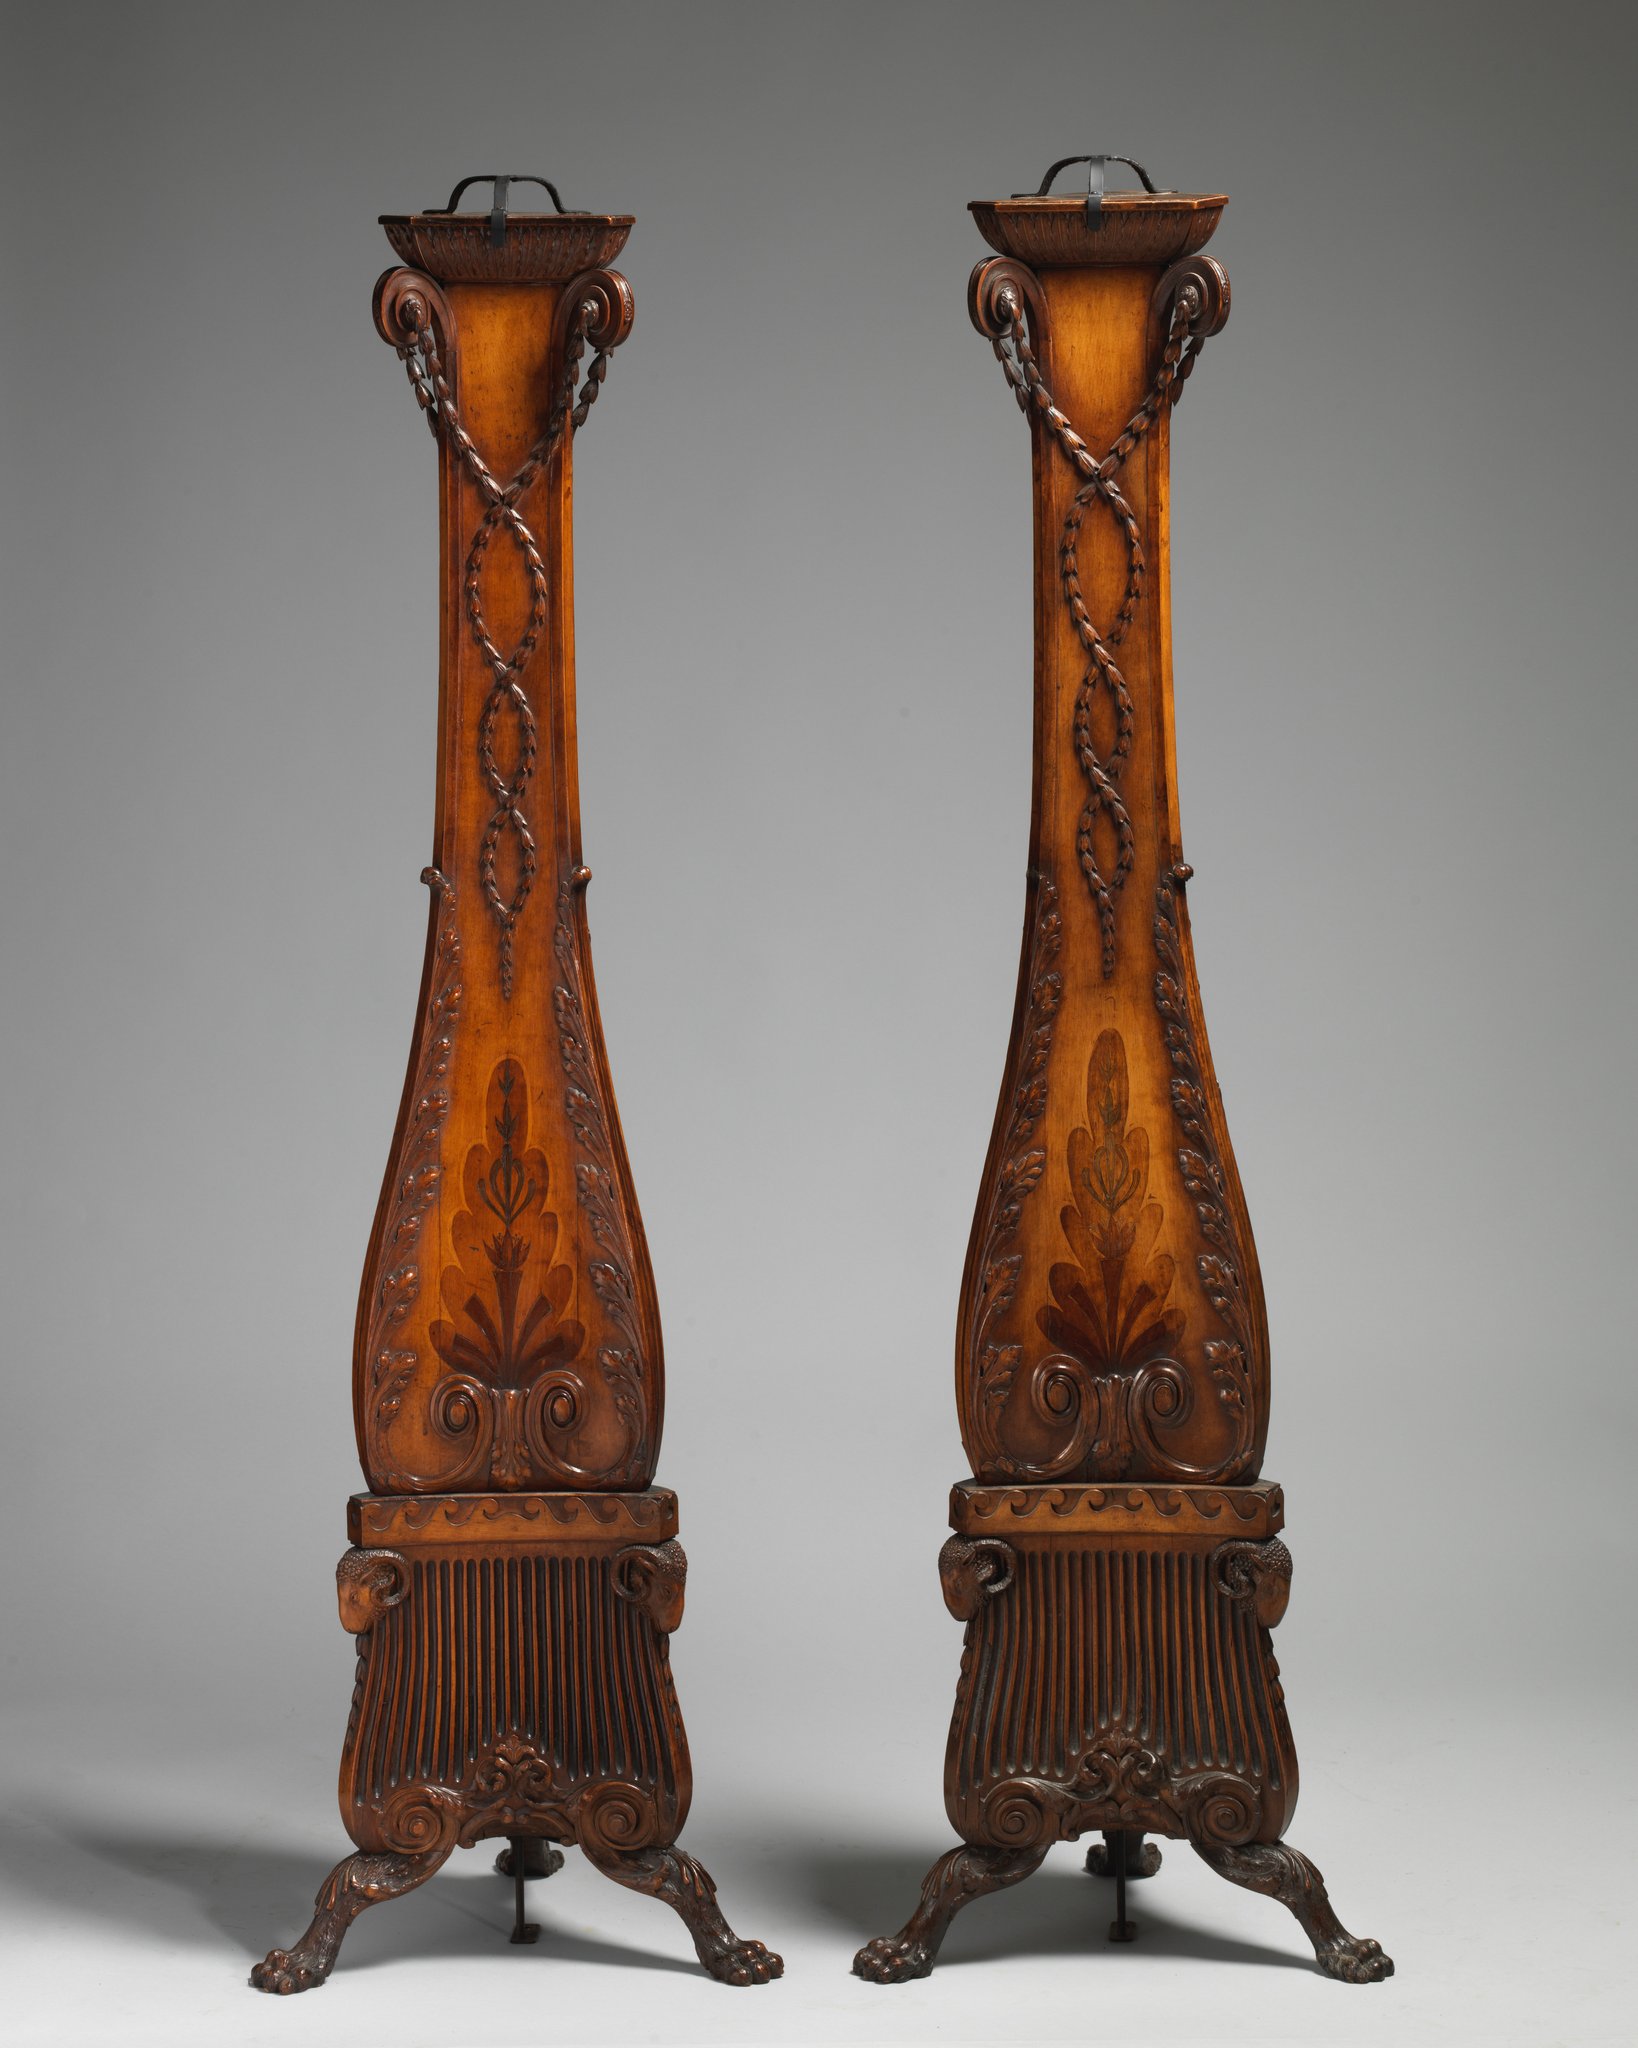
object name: pedestal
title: Pair of pedestals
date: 1780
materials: wood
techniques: inlay, veneering